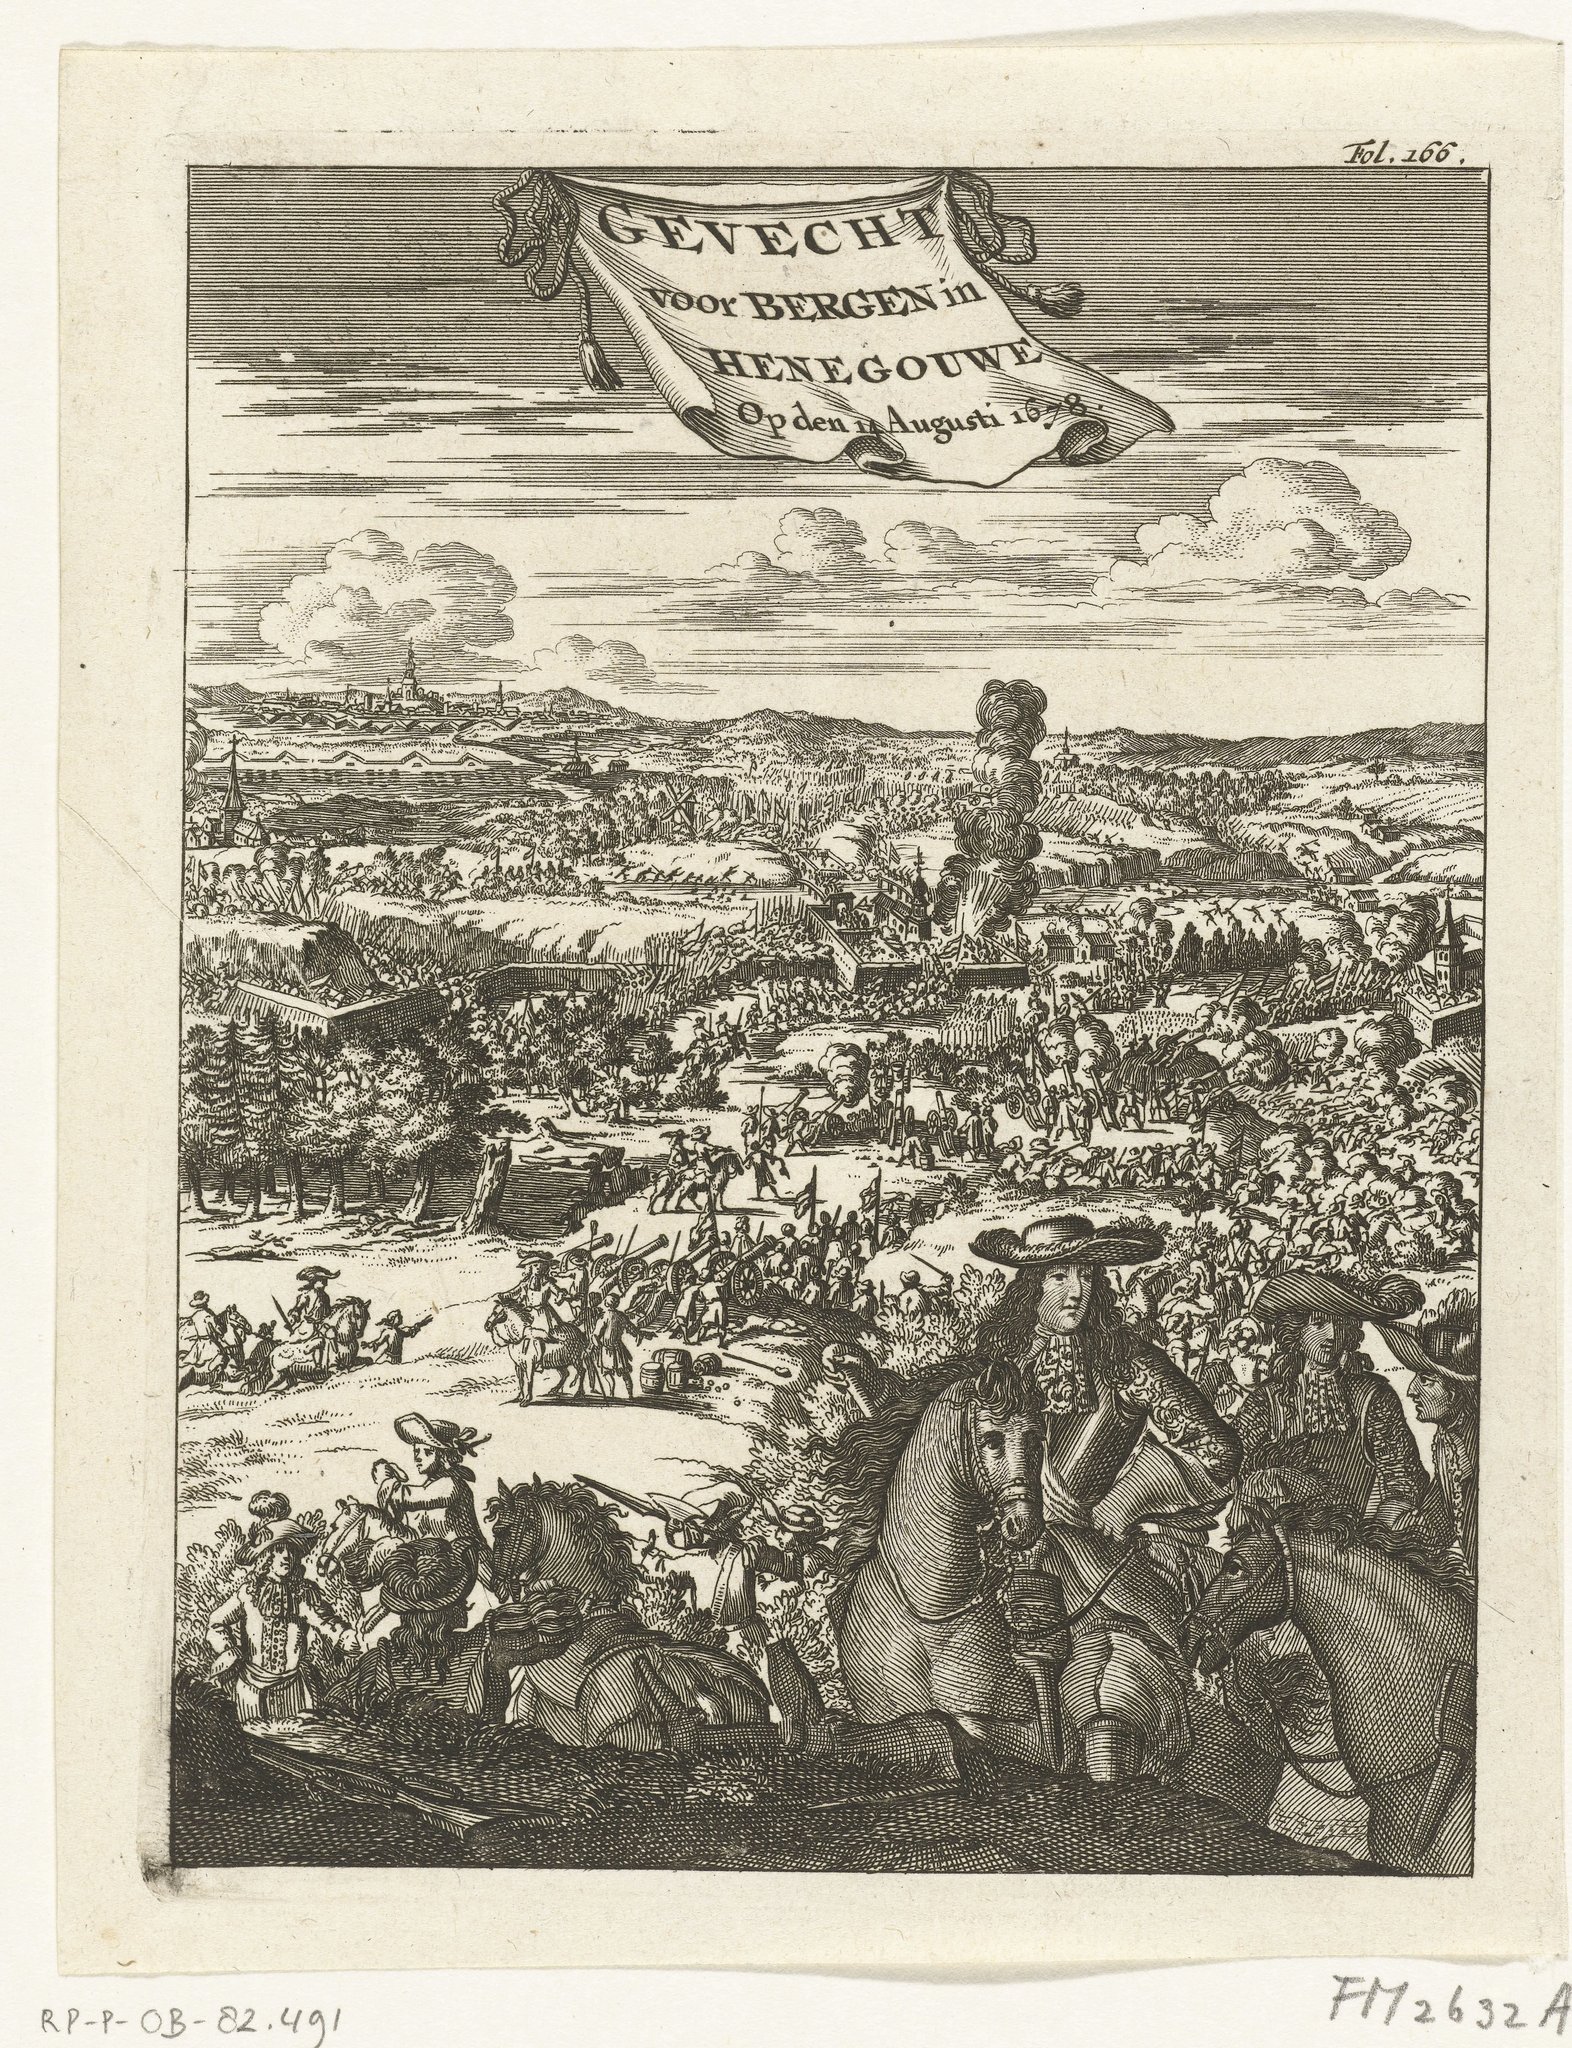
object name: history print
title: Gevecht voor Bergen in Henegouwe Op den 11 Augusti 1678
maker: Anonymous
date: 1678-1679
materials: paper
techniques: engraving, etching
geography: northern netherlands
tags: william iii (prince of orange and king of england, scotland, and ireland), battle (+ land forces)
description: De slag bij St. Denis bij Bergen op 14 augustus 1678 tussen een geallieerd leger onder Willem III en het Franse leger. Gezicht op het slagveld, op de voorgrond officieren te paard. Gemerkt rechtsboven: Fol. 166